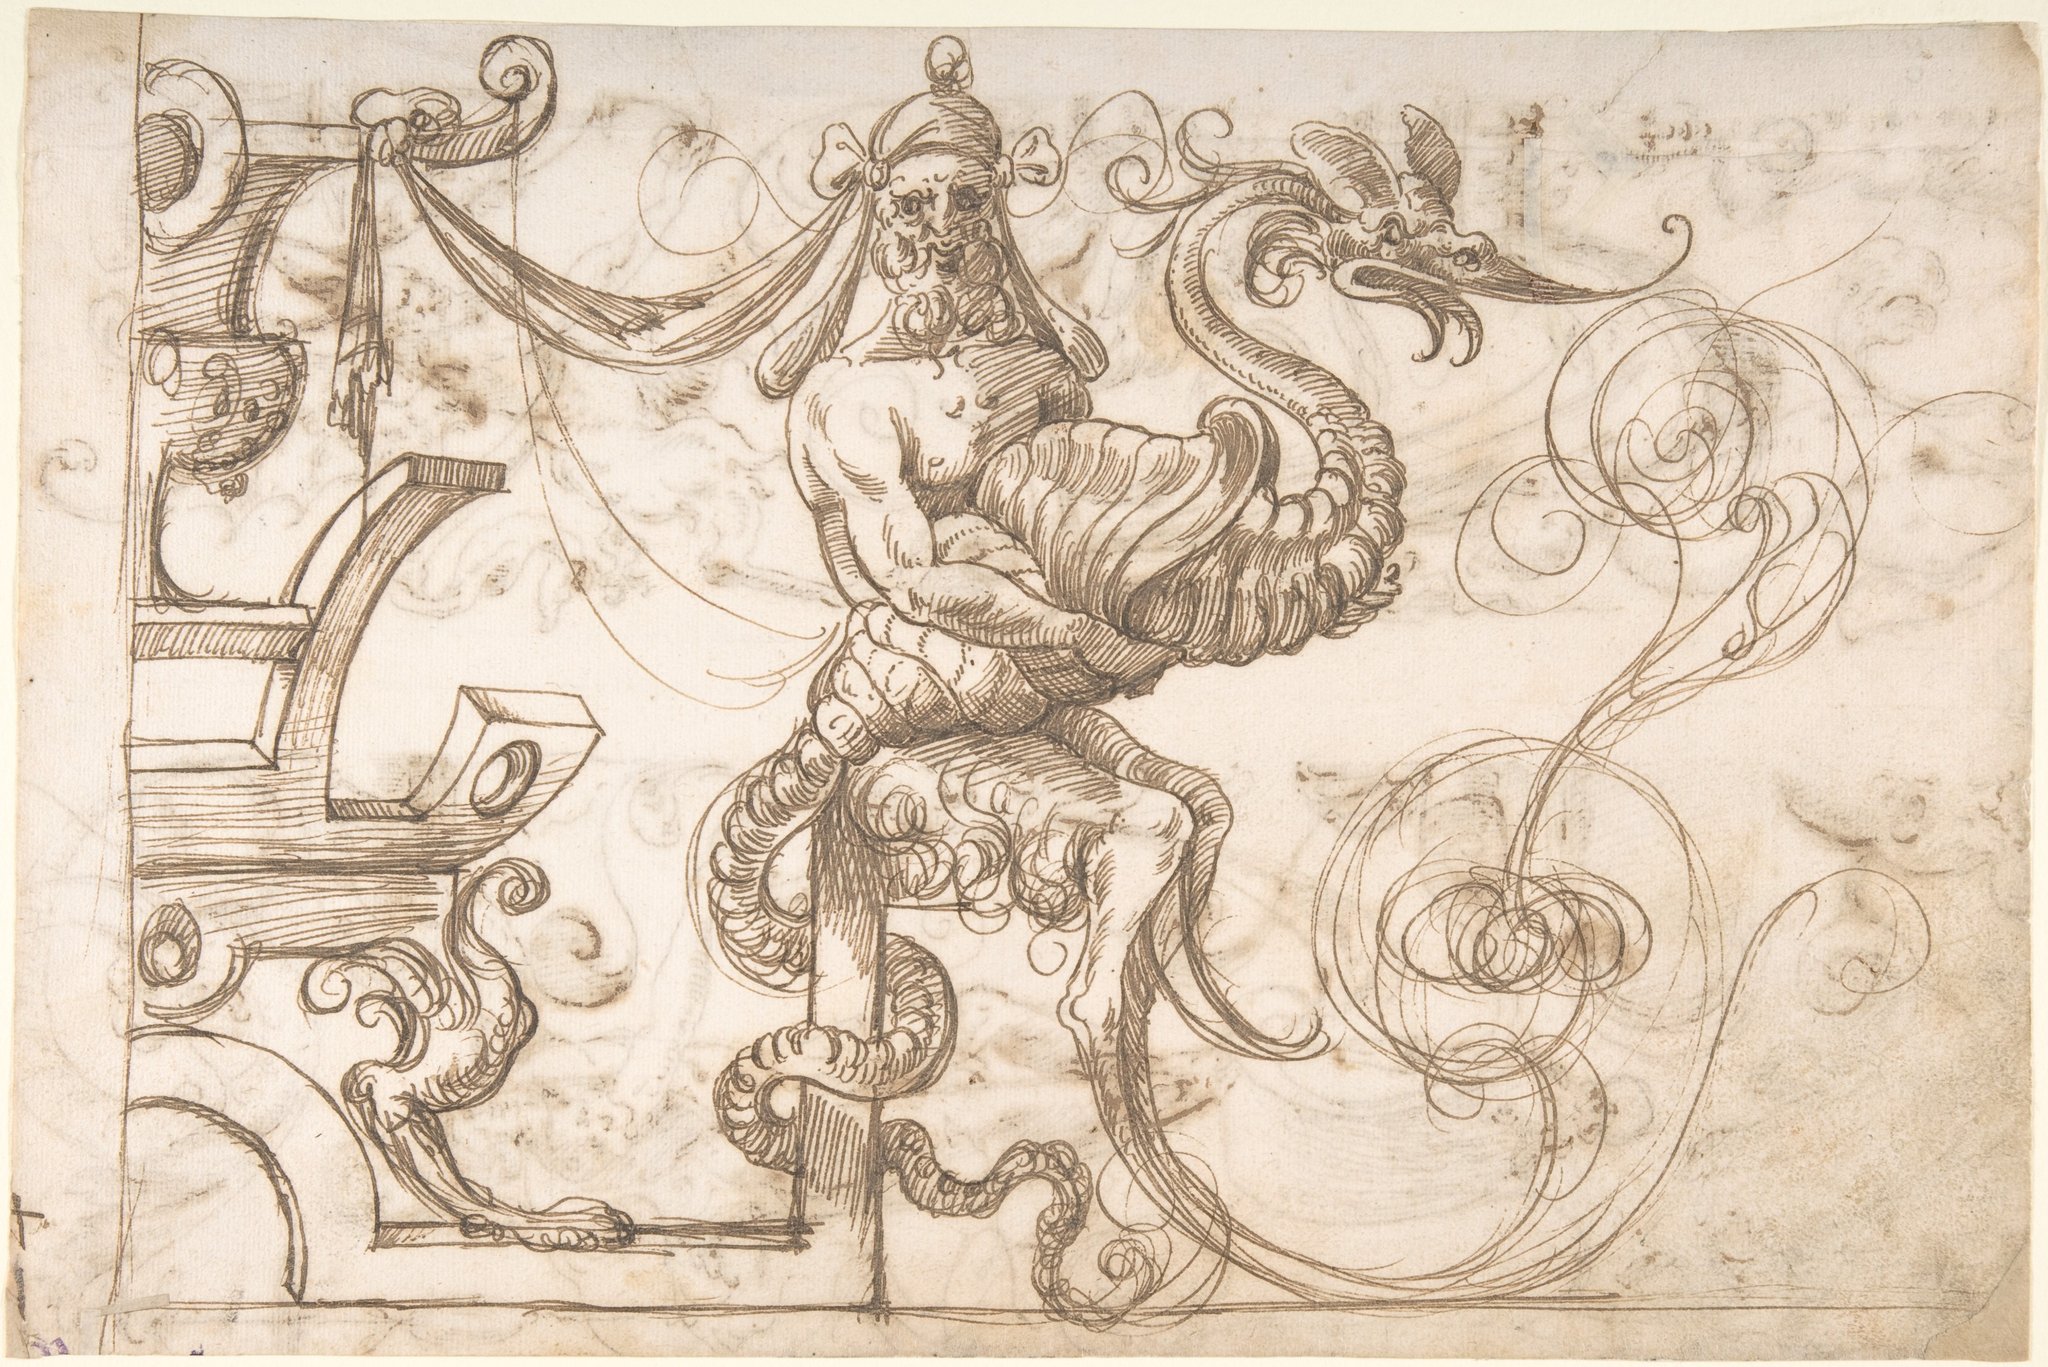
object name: drawing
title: Satyr holding a fantastical creature (recto); Two candelabra grotesques (verso)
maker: andrés de melgar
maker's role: artist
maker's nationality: spanish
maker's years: 1554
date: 1545-1560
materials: ink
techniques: pen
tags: mythical creatures,satyrs